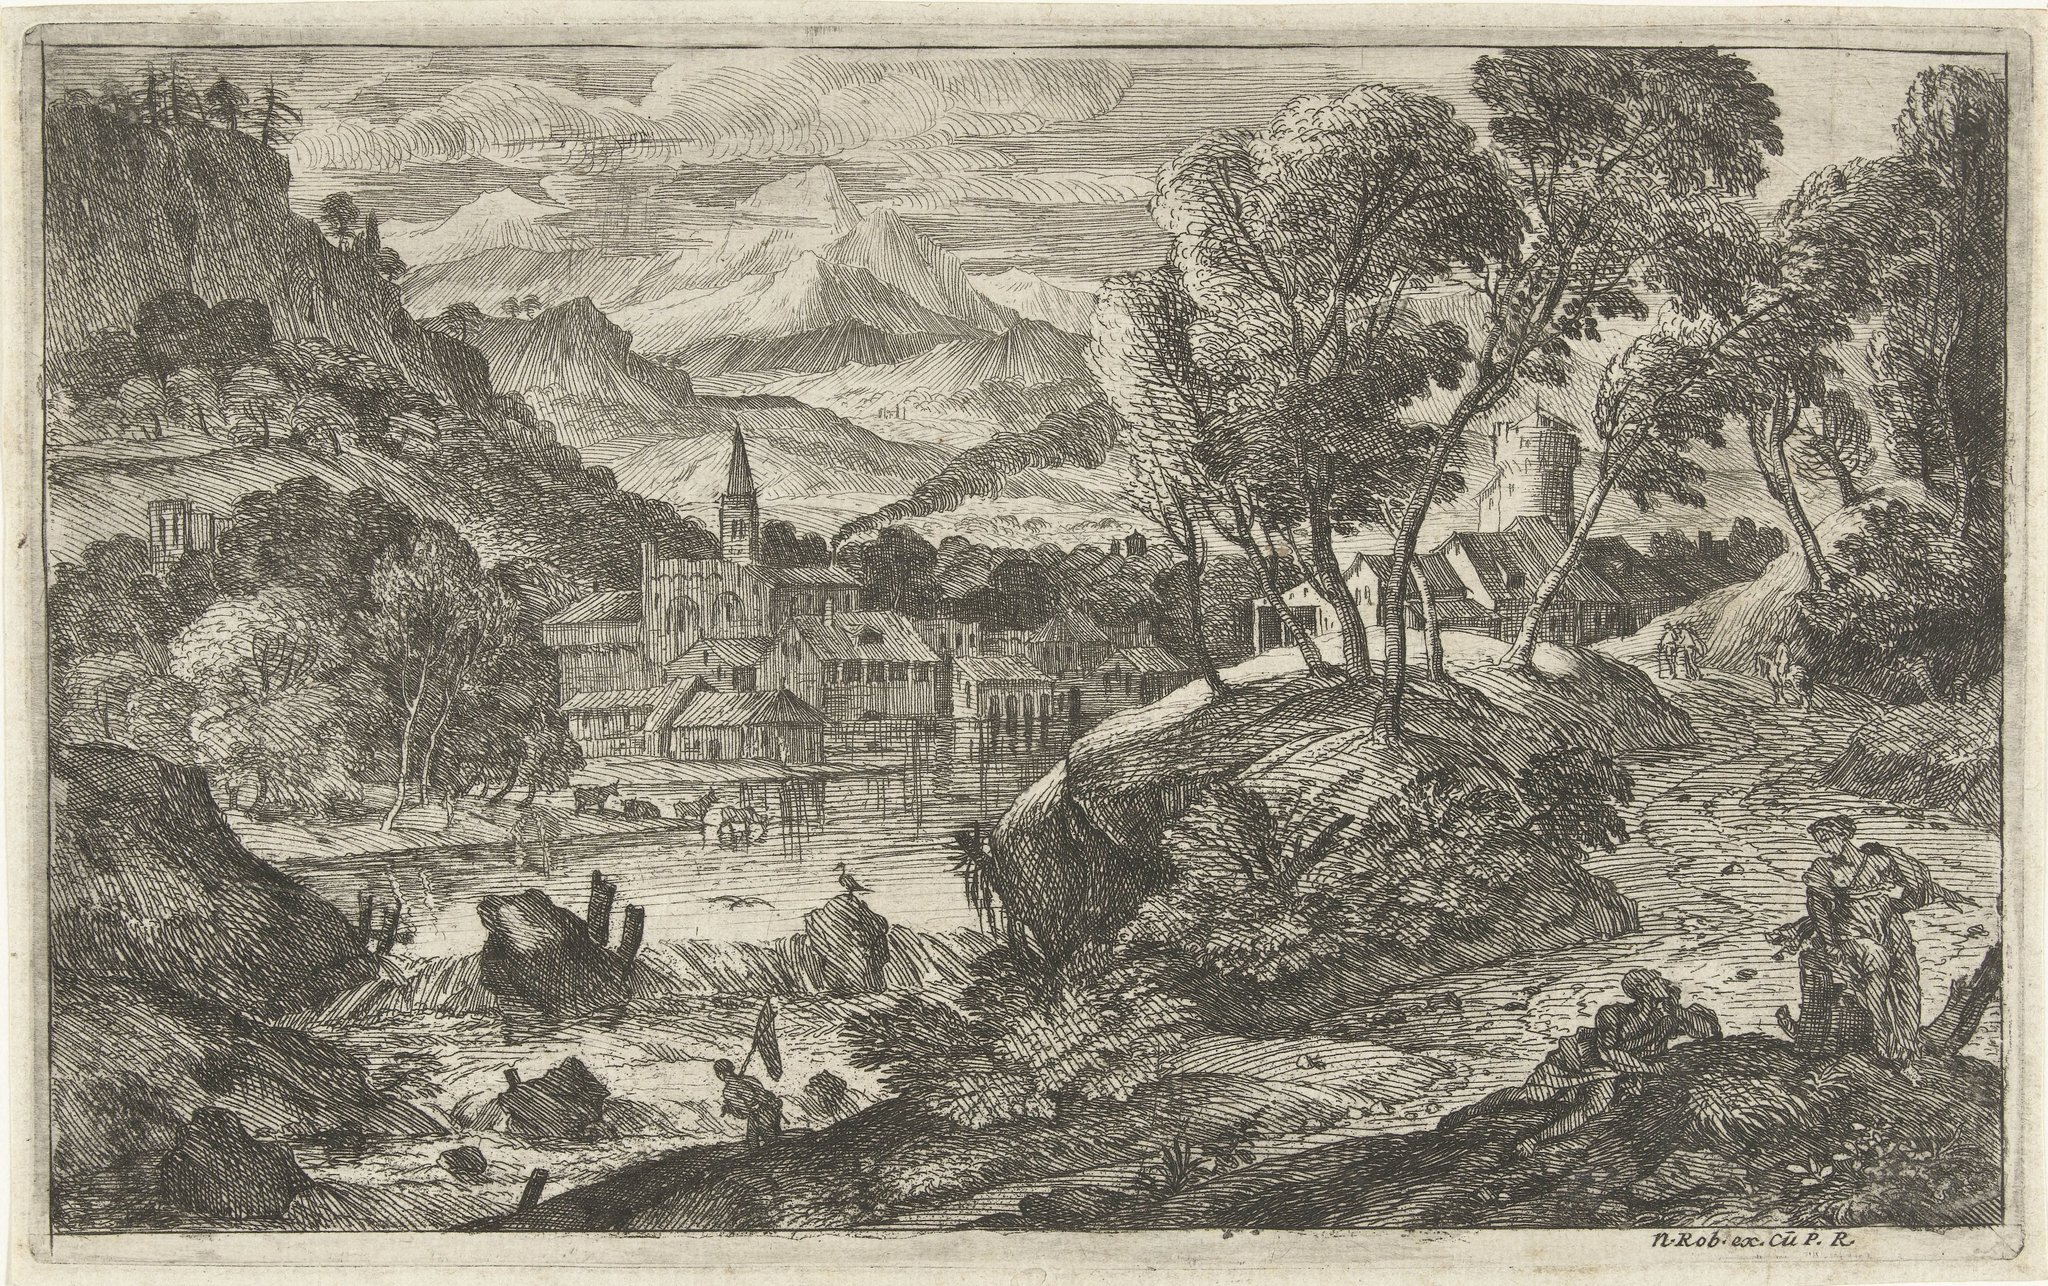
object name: print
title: Landschap met waterval en dorp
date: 1648-1705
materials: paper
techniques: etching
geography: france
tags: landscapes, sports, games ~ animals (+ net)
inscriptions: collector's mark: Lugt 2228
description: Landschap met op de voorgrond rechts, een staande vrouw pratend met liggende man. Links van het midden een jongen met visnet staand bij rivier met waterval. Op de achtergrond een dorp aan het water.